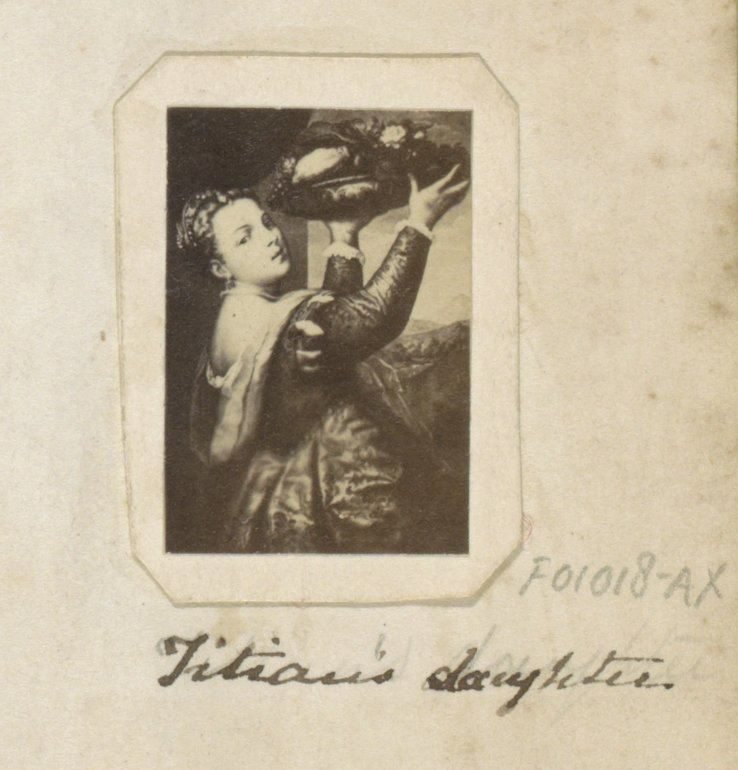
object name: reproduction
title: Titians daughter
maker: Anonymous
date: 1860-1870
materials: cardboard, paper, photographic support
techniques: albumen print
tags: restaurant (+ waiter, waitress, etc.), fruits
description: Onderdeel van Engels familiealbum met foto's van personen, reizen, cricket en kunstwerken.